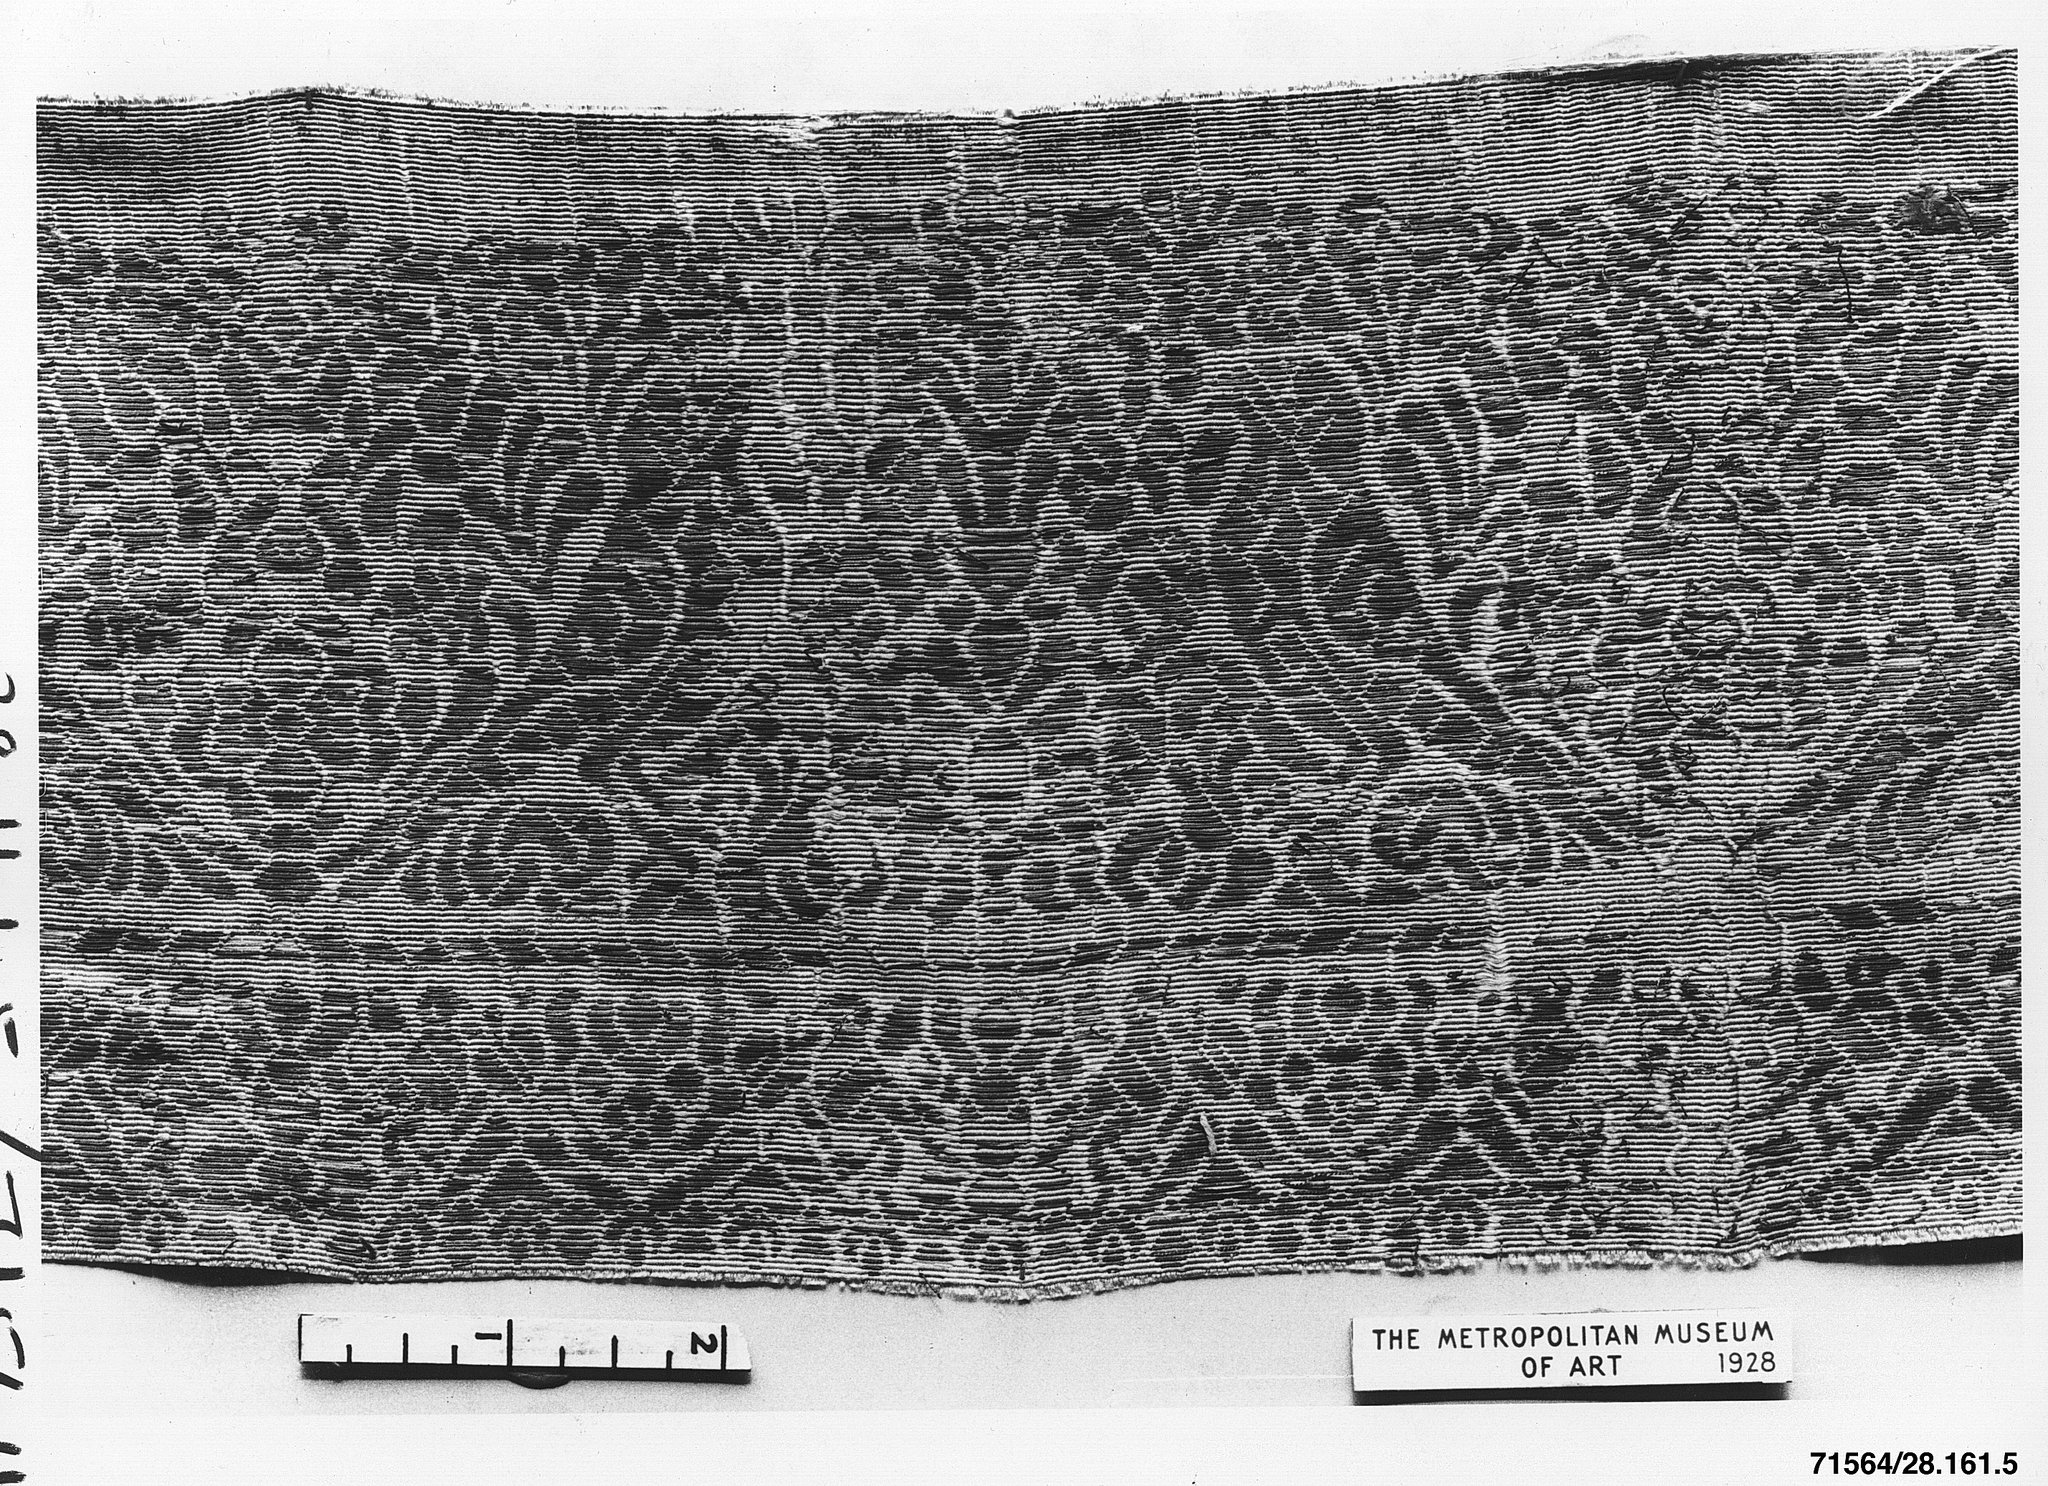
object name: piece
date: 1501-1600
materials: metal thread, silk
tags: birds